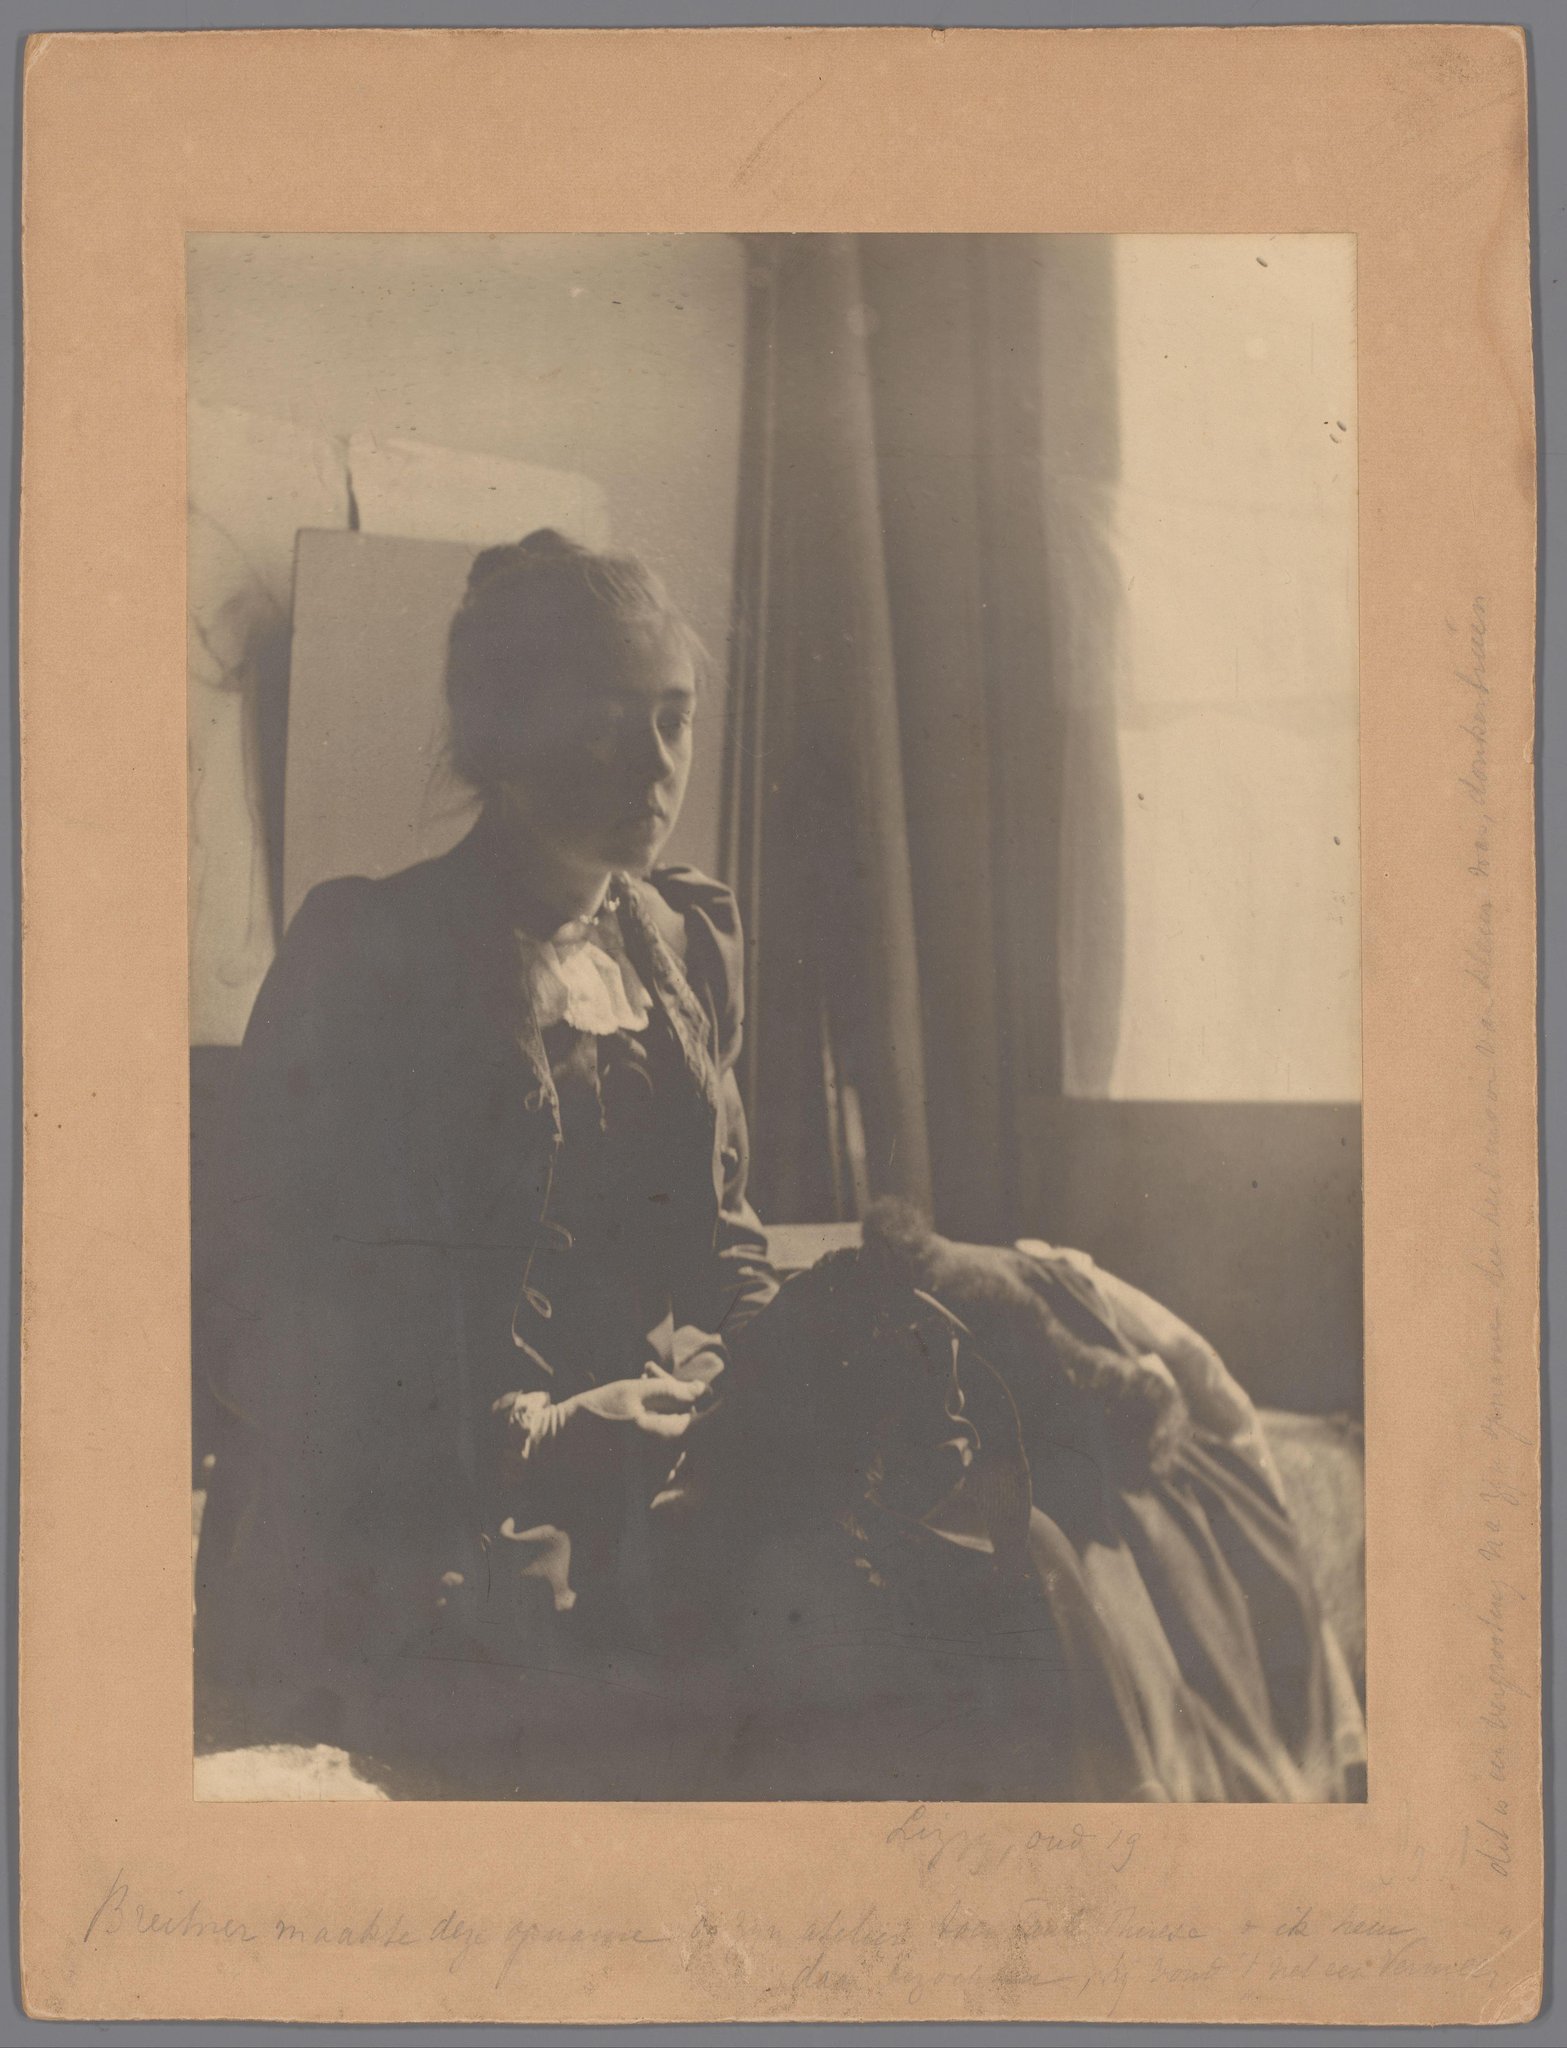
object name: photograph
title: Portret van Lizzy Ansingh, in Breitners atelier aan de Lauriergracht, Amsterdam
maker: george hendrik breitner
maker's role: draughtsman, painter, print maker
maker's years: 1857-1923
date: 1894-1895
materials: paper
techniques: gelatin silver print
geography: amsterdam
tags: utrecht, painter, lizzy ansingh, historical persons - bb - woman, portrait, self-portrait of artist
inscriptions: annotation: ‘Lizzy, oud 19 / Breitner maakte deze opname op zijn atelier toen tante Therese en ik hem daar bezochten; hij vond 't net een Vermeer. dit is een vergrooting na[ar] zijn opname die heel mooi van kleur was, donkerbruin [vgl. voor de hand van Lizzy Ansingh waarin deze aantekening is geschreven: RP-F-1974-63-3].’